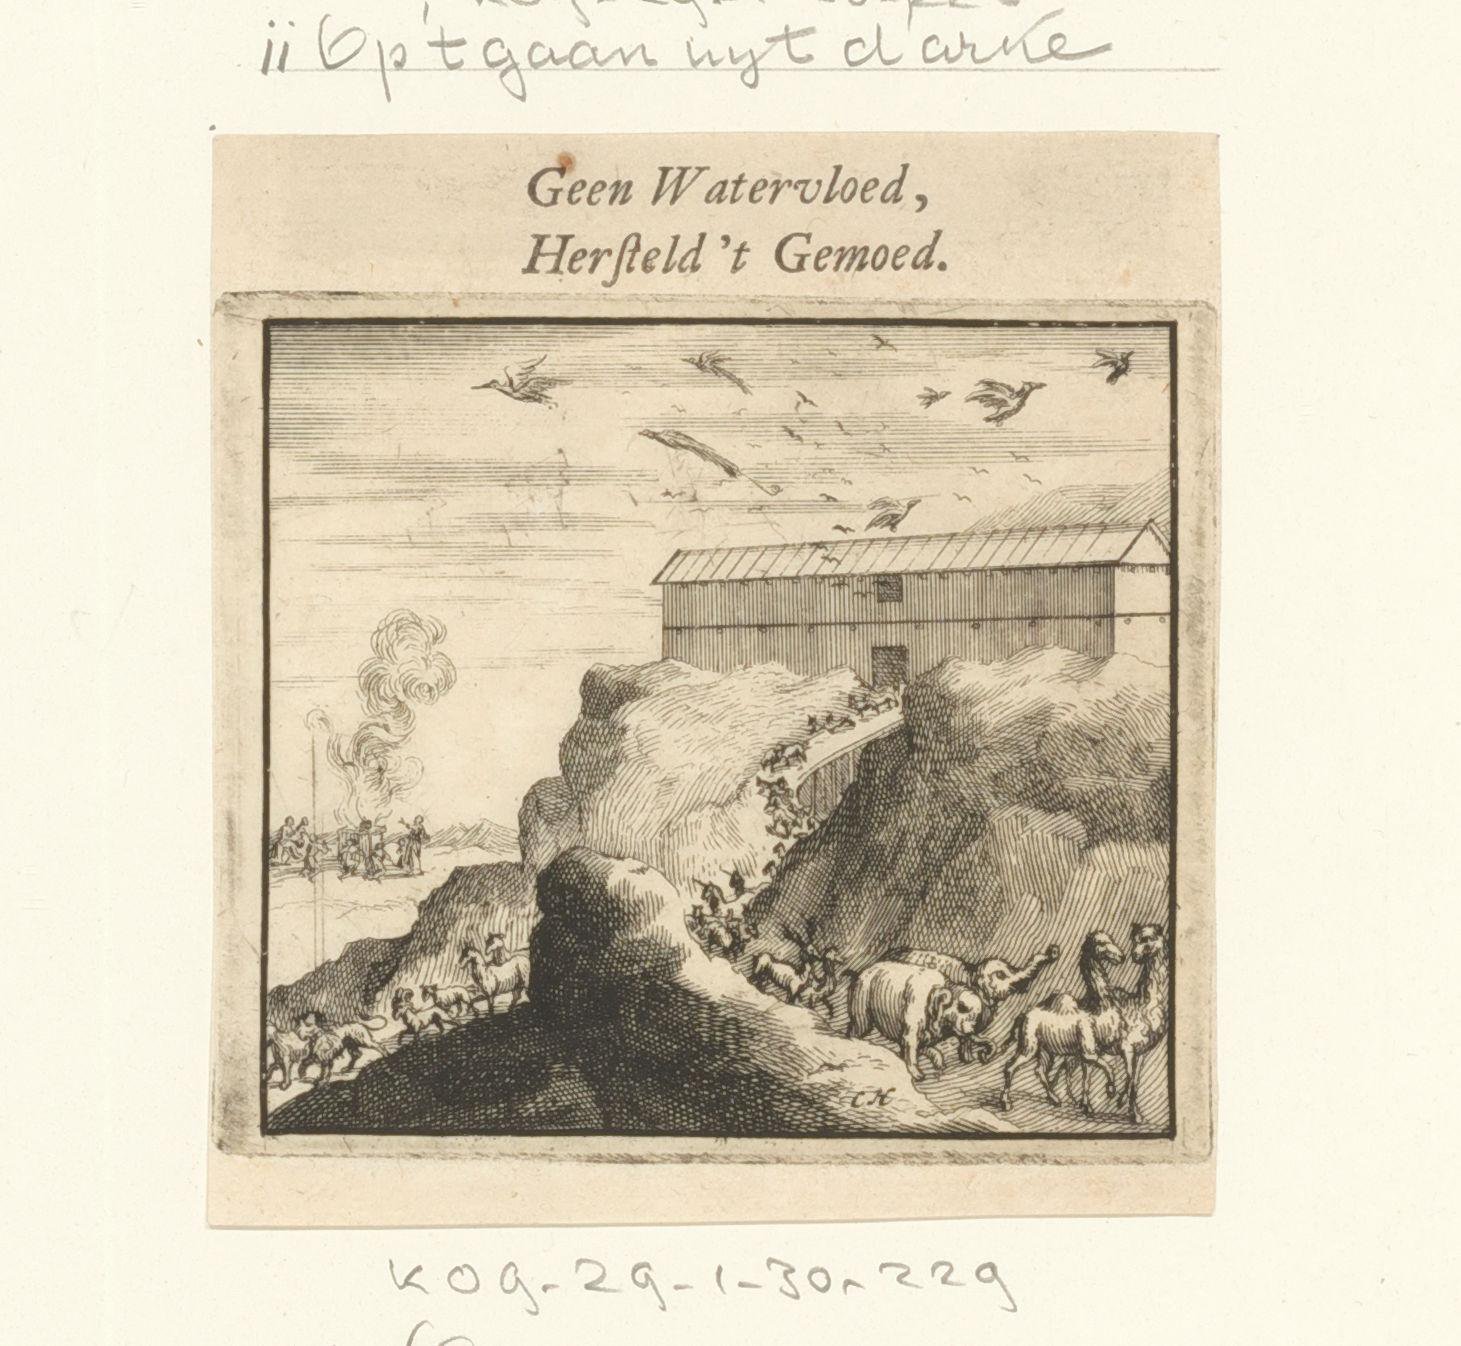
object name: print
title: Geen Watervloed, Hersteld 't Gemoed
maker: cornelis huyberts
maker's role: print maker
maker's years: 1669-1709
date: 1725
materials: paper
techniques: etching, letterpress printing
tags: story of noah, the disembarkation ~ story of noah (genesis 8:18 - 9:17), noah's sacrifice; various animals are offered, possibly a lamb, a dove and a ram (often combined with the rainbow of the covenant), noah, his family and the animals leave the ark (sometimes combined with the rainbow of the covenant)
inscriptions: stamp, collector's mark: Lugt 1641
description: Prent uit: Graauwhart, Hendrik. Voorbeeldelyke zeede-lessen, genoomen uyt den eersten toestand des werelds (...). Amsterdam: Johannes Ratelband, 1725. Prent ook gebruikt voor eerdere en (1709) latere uitgave (1756, 1761 en 1764).